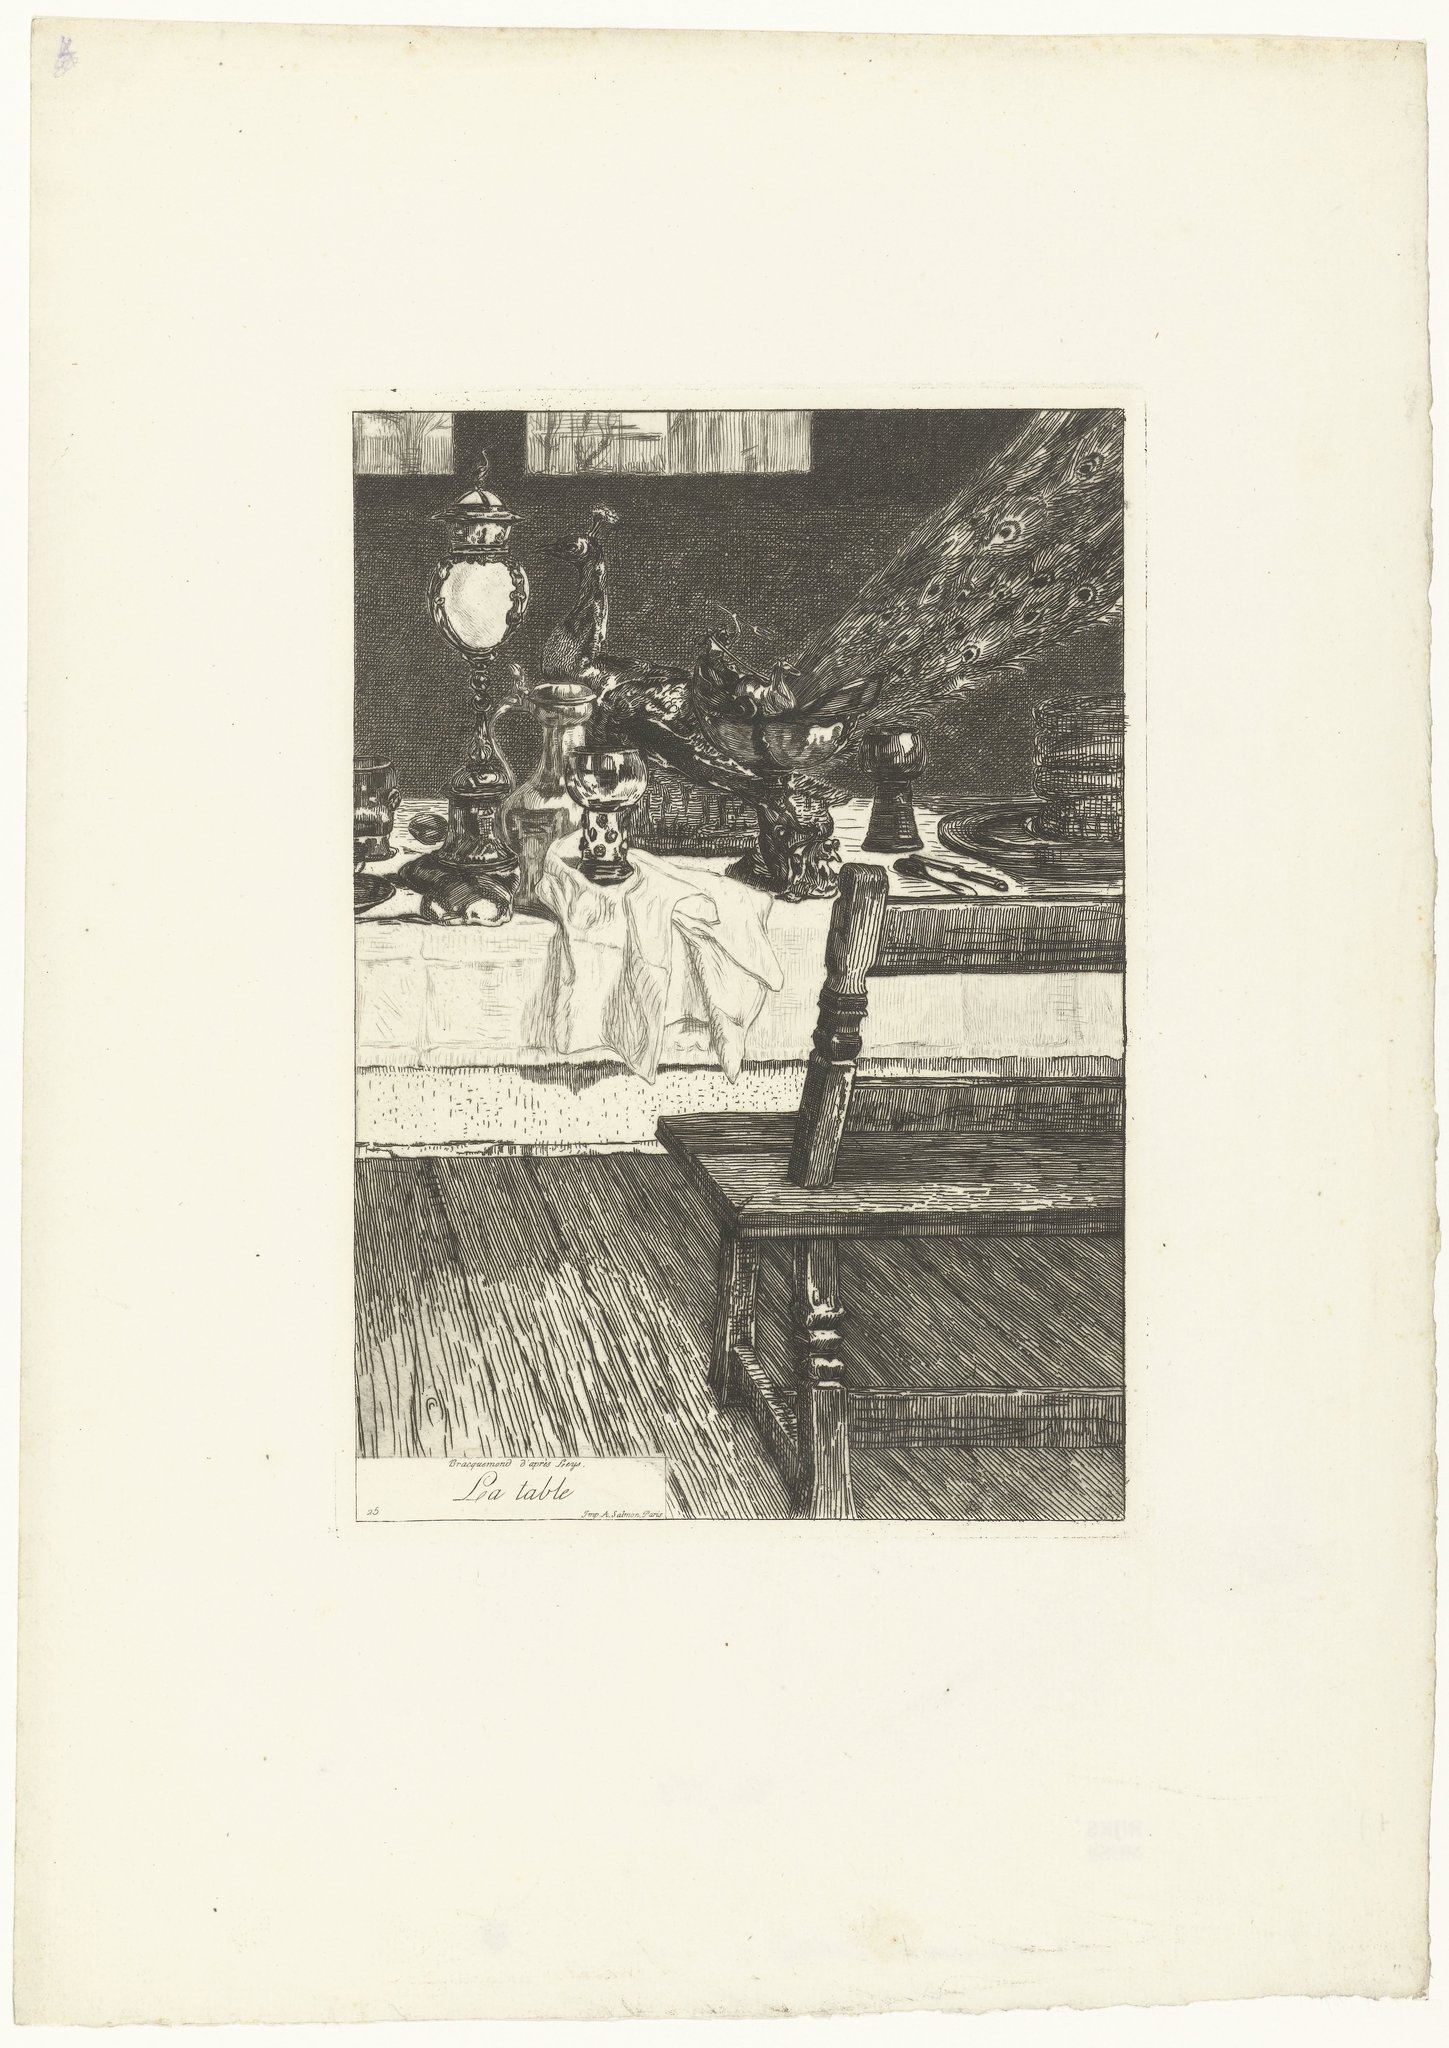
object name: print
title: La Table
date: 1860-1914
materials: paper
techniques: etching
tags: cake, tart, pastry, laid table: table-ware, table-decoration, etc.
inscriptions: collector's mark: Lugt 2760, collector's mark: Lugt 2233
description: Op een gedekte tafel staan verschillende voorwerpen bekend uit zeventiende-eeuwse stillevens zoals glazen, een nautilusbeker, een tinnen kan en een pastei gedecoreerd als een pauw. Voor de tafel staat een houten bank.